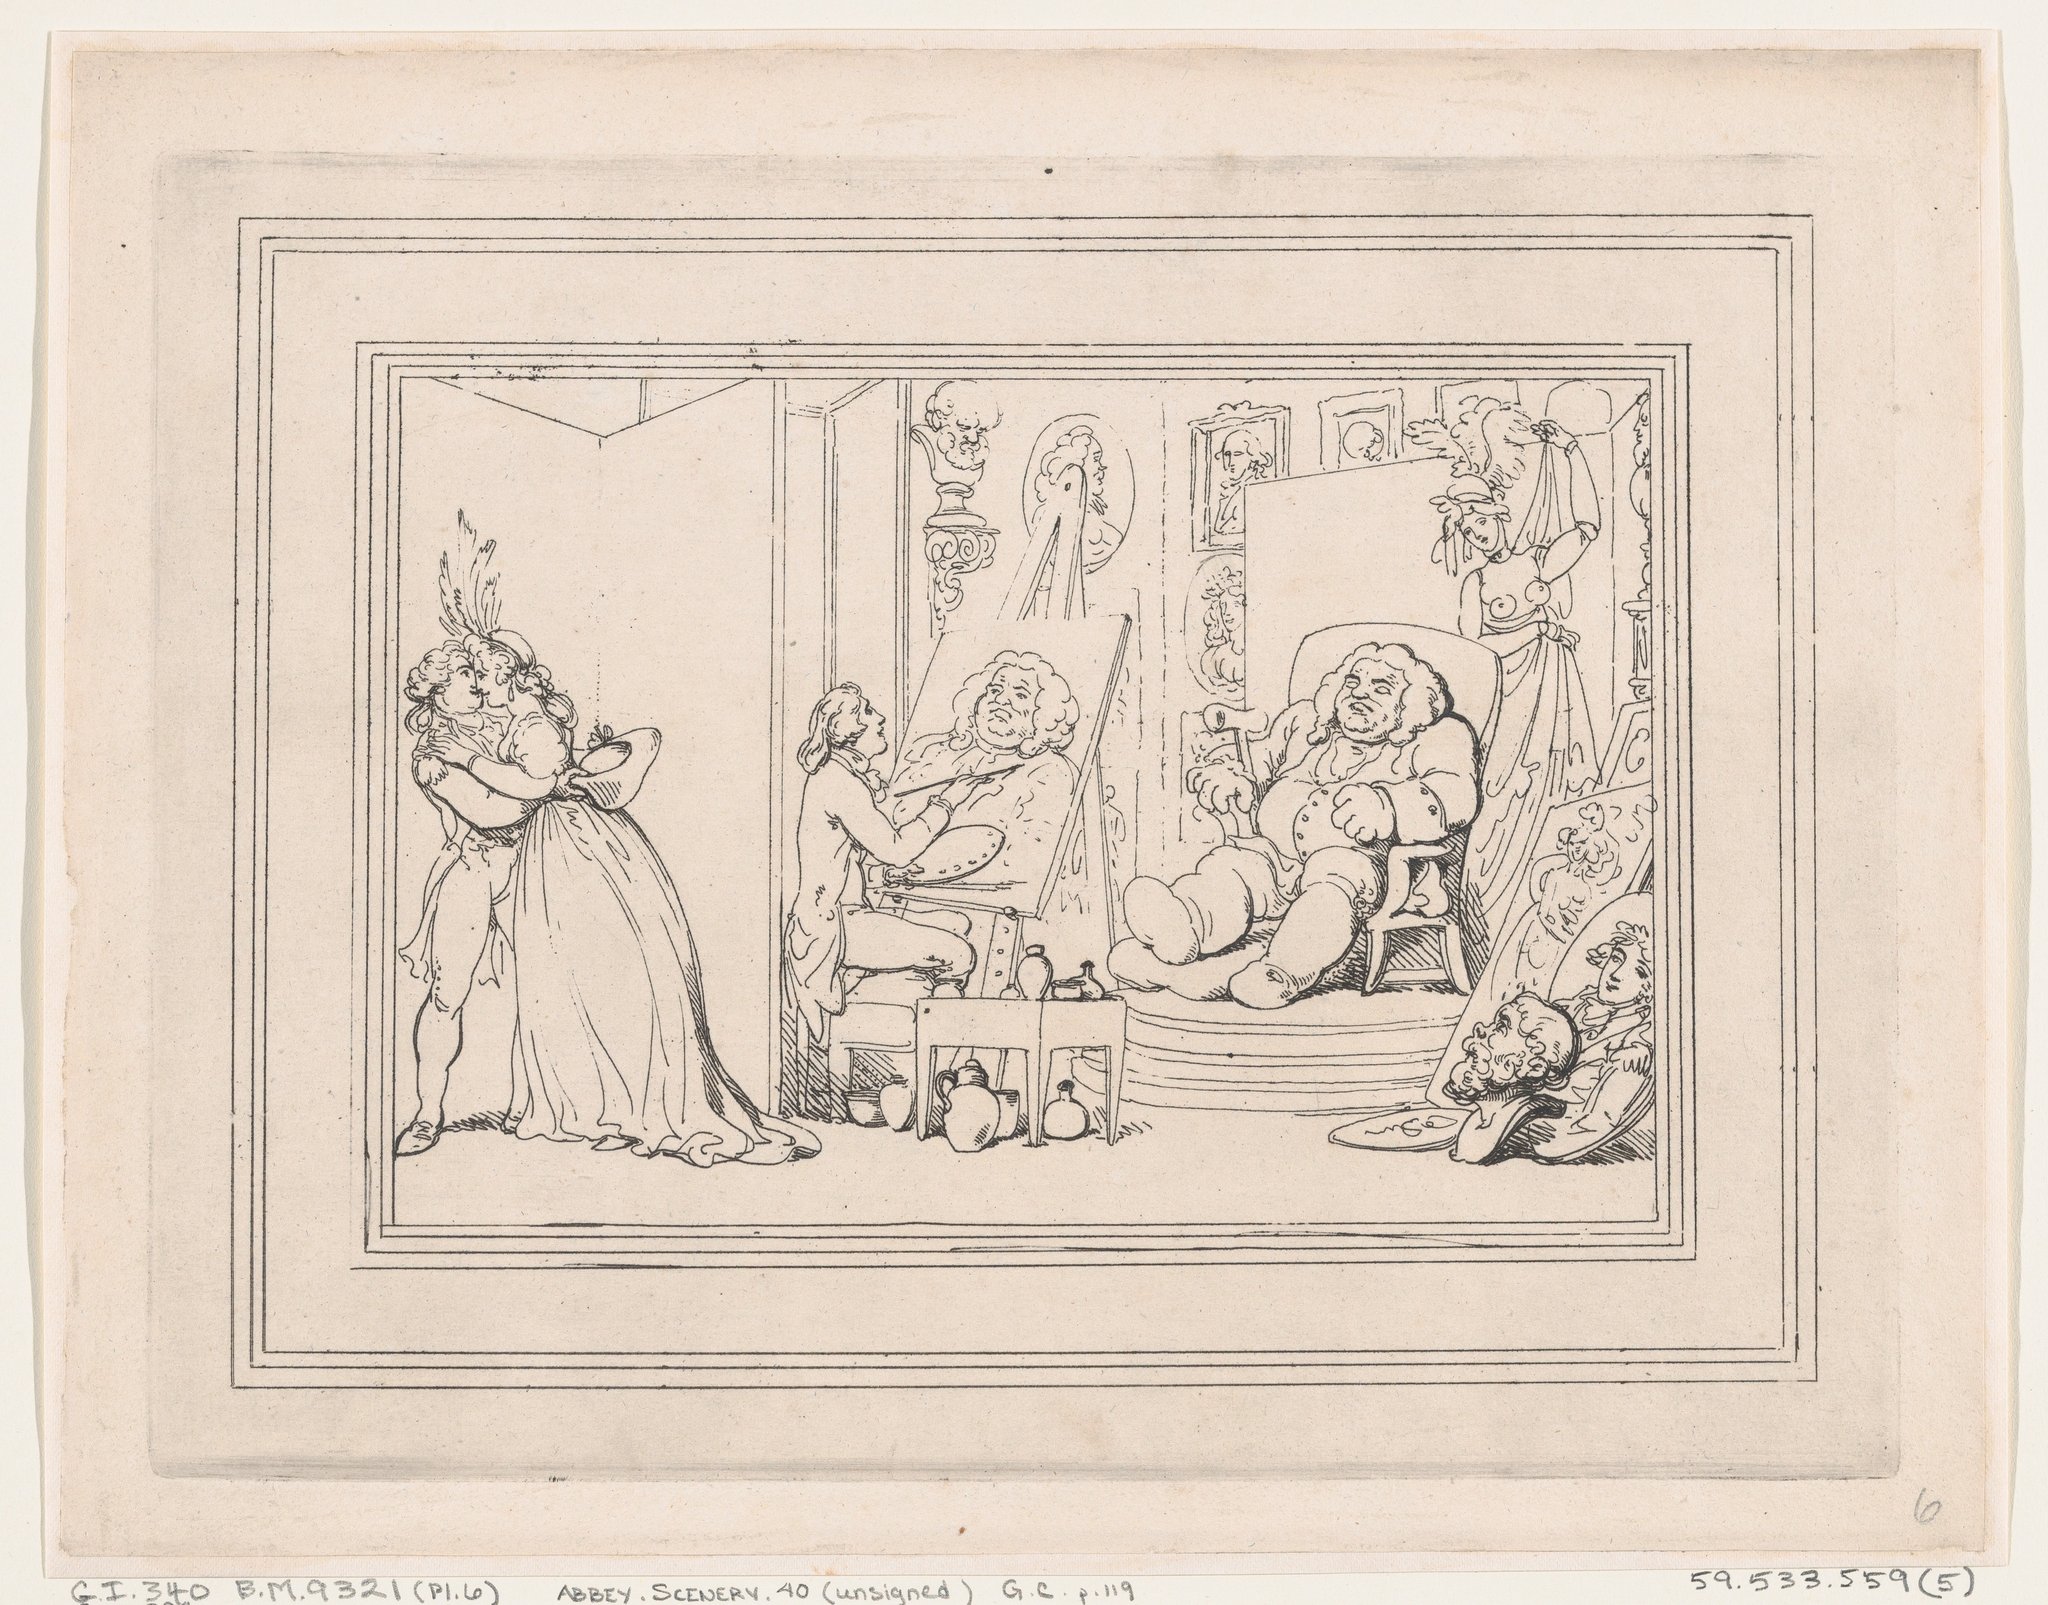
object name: print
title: Comforts of Bath, Plate 6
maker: thomas rowlandson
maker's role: artist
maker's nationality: british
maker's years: 1757-1827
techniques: etching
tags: painting,men,women